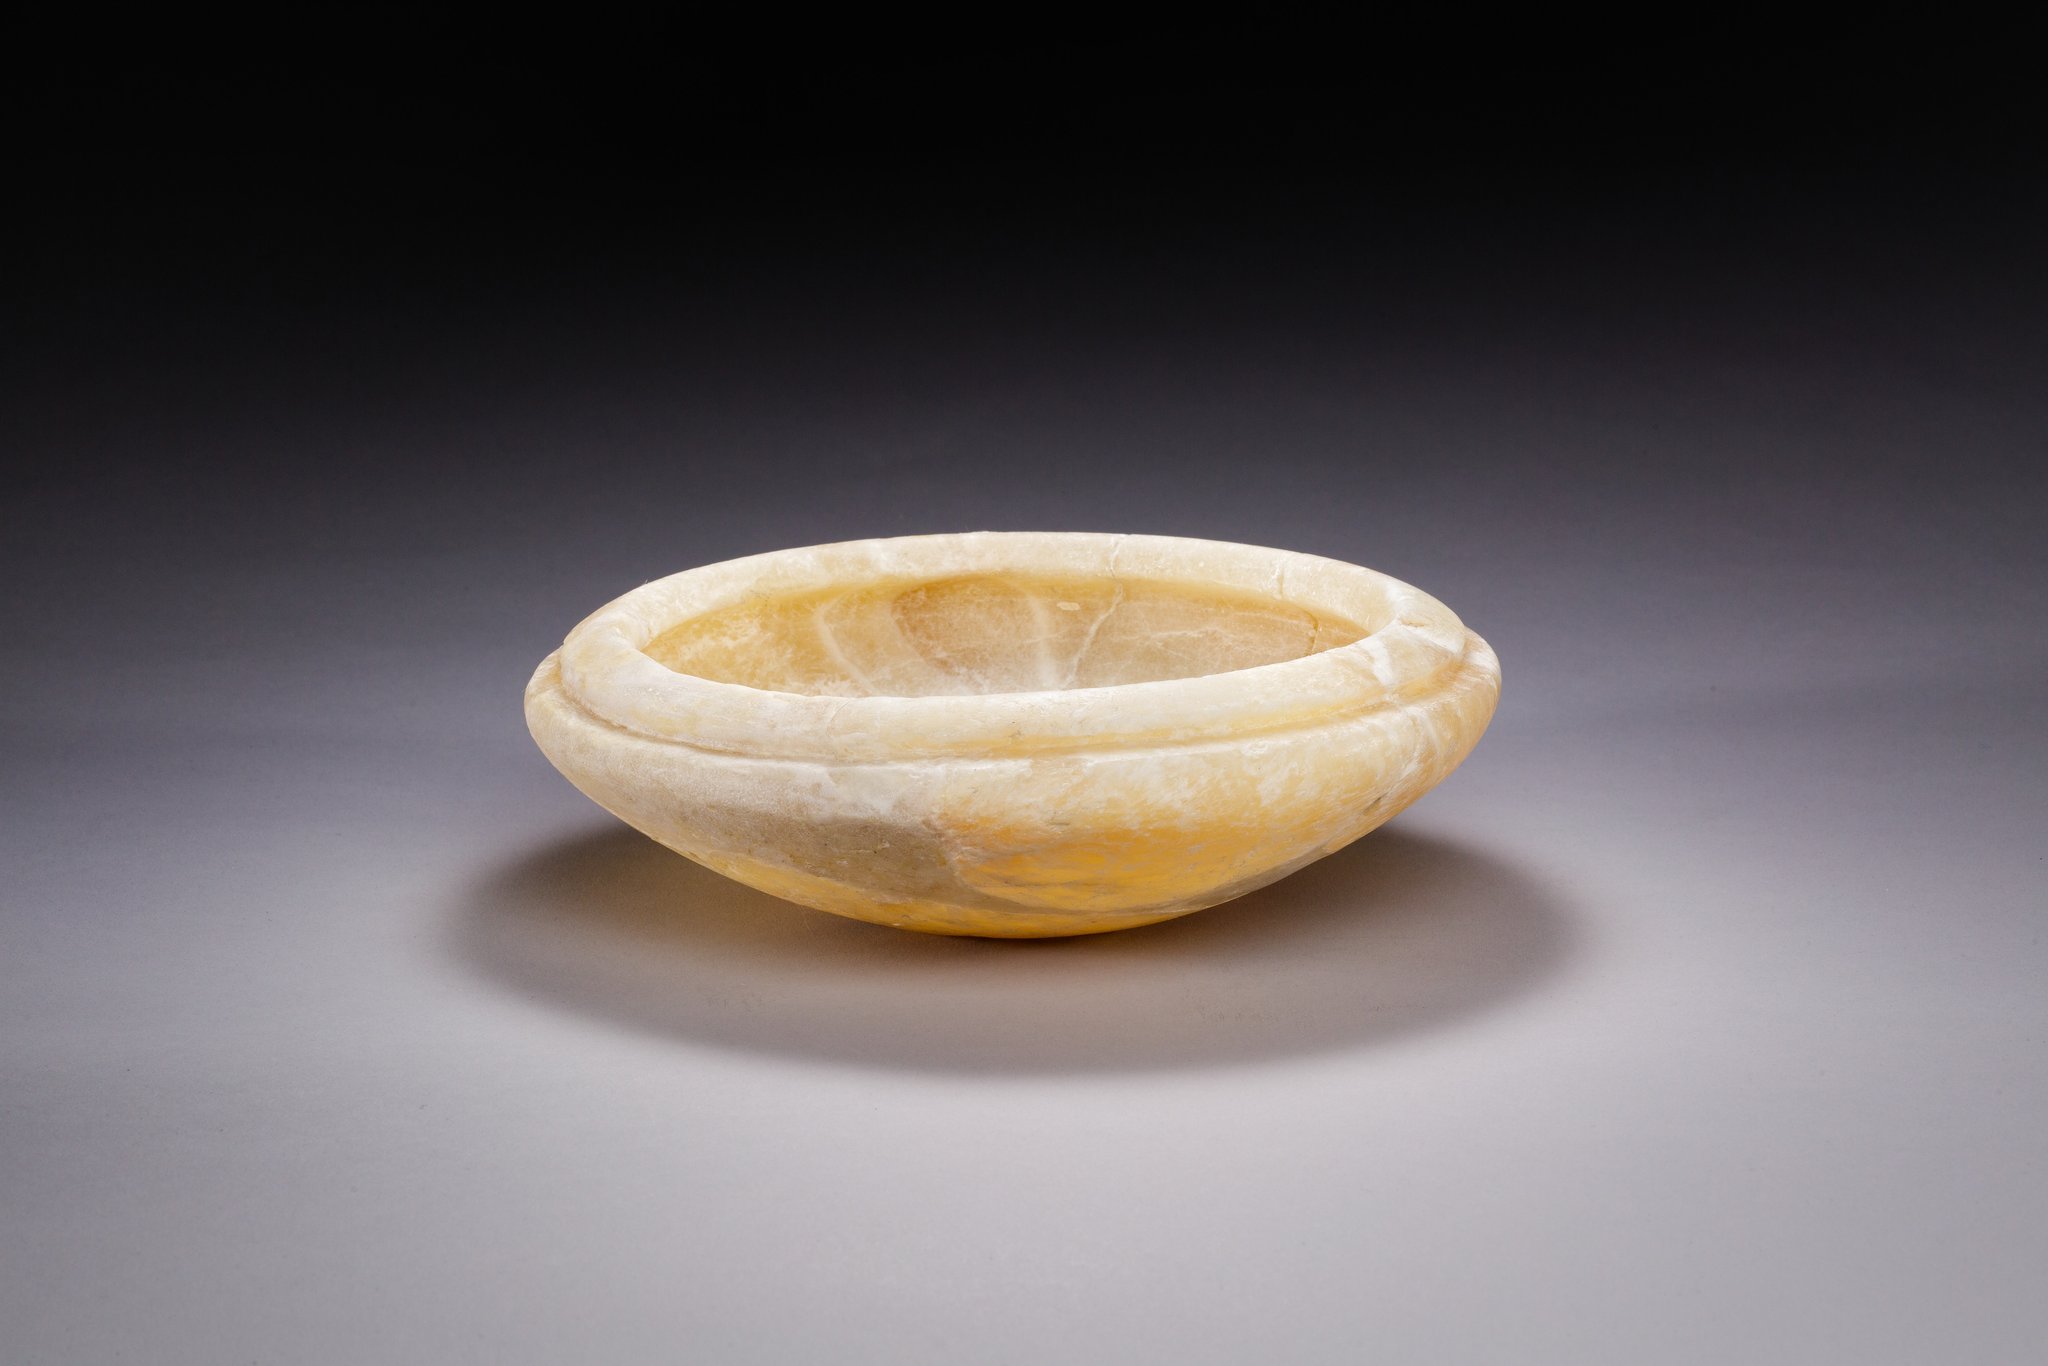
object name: bowl, rimmed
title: Large Rimmed Bowl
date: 2750-2649 BCE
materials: stone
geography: egypt